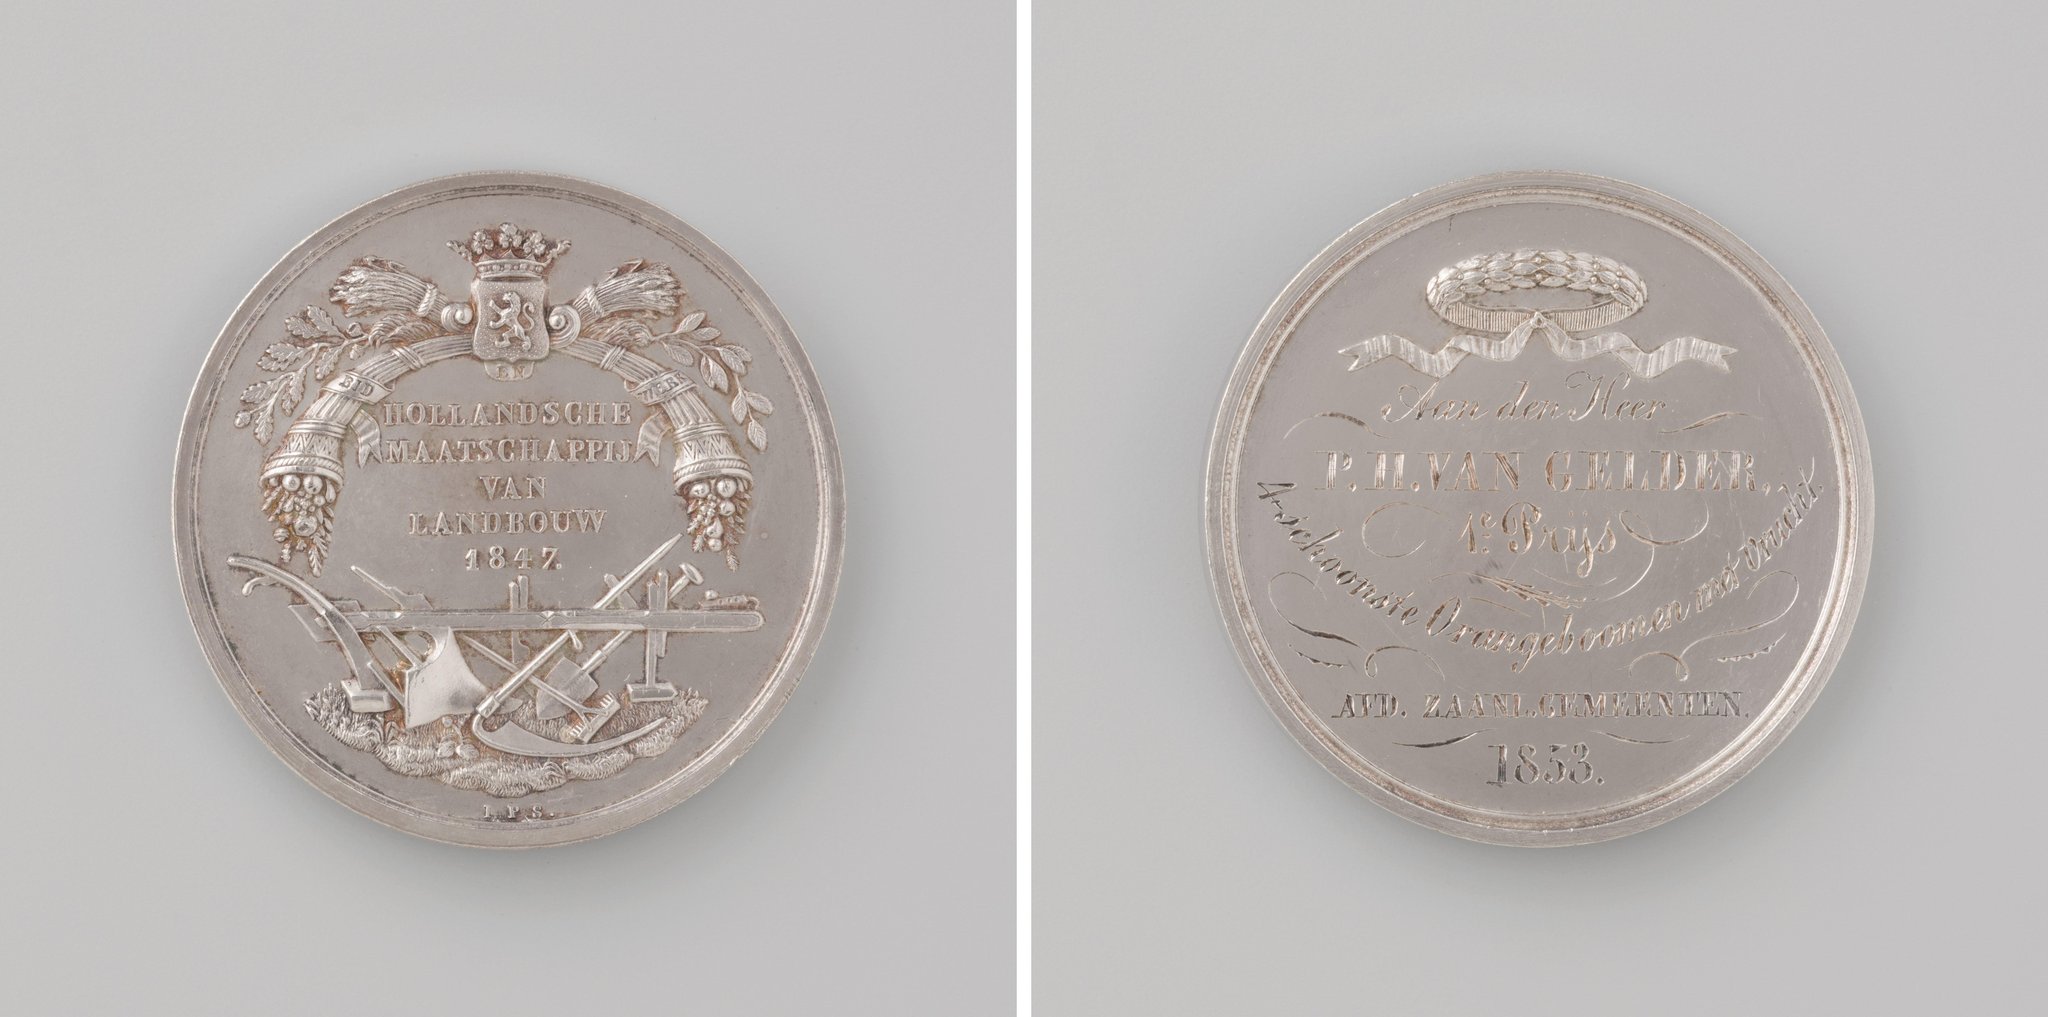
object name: medal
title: Afdeling Zaanlandse gemeenten van de Hollandsche Maatschappij van Landbouw, penning als eerste prijs uitgereikt aan P.H. van Gelder voor de vier mooiste vruchtdragende oranjebomen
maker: johannis petrus schouberg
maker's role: die cutter, draughtsman, print maker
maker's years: 1798-1864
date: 1853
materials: silver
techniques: engraving, striking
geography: utrecht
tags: holland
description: Zilveren penning. Voorzijde: gekroond wapenschild liggend op twee korenschoven, twee omgekeerde, gevulde hoorns van overvloed, een eike- en een wilgetak boven opschrift en landbouwwerktuigen. Keerzijde: krans van olijftakken met lint boven opschriften